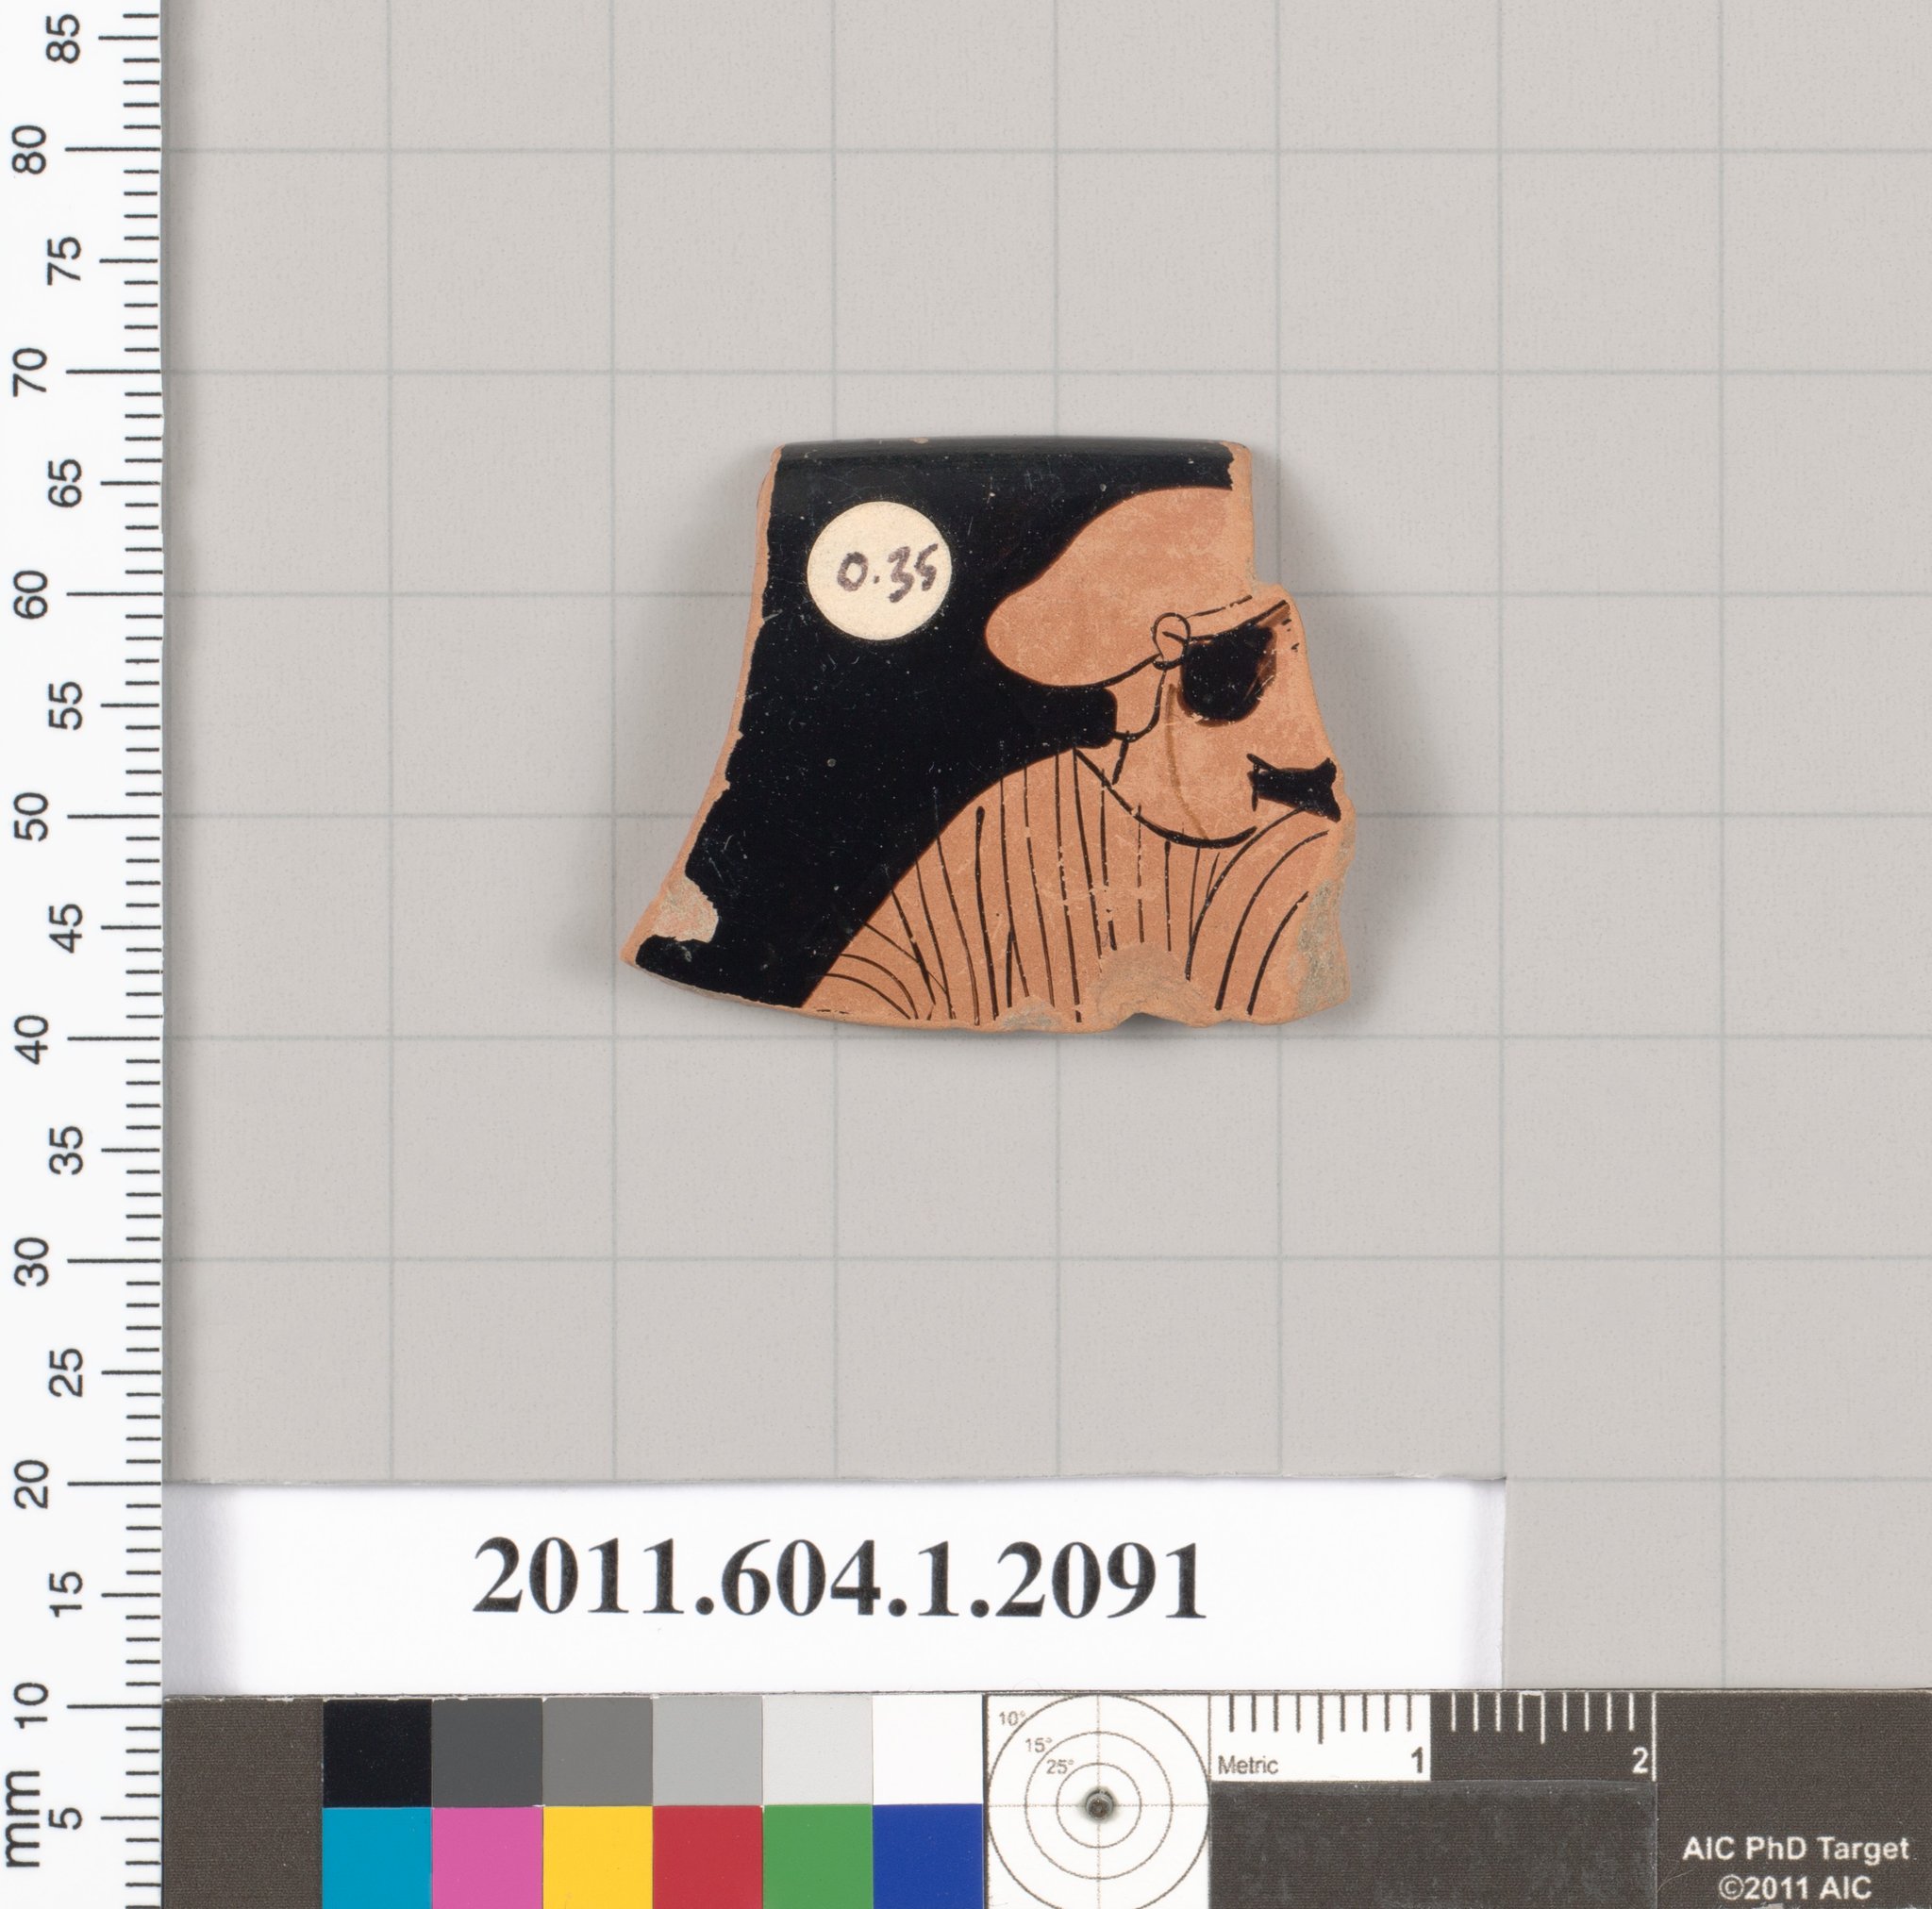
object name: kylix fragment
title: Terracotta rim fragment of a kylix (drinking cup)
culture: greek, attic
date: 490-470 BCE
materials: terracotta